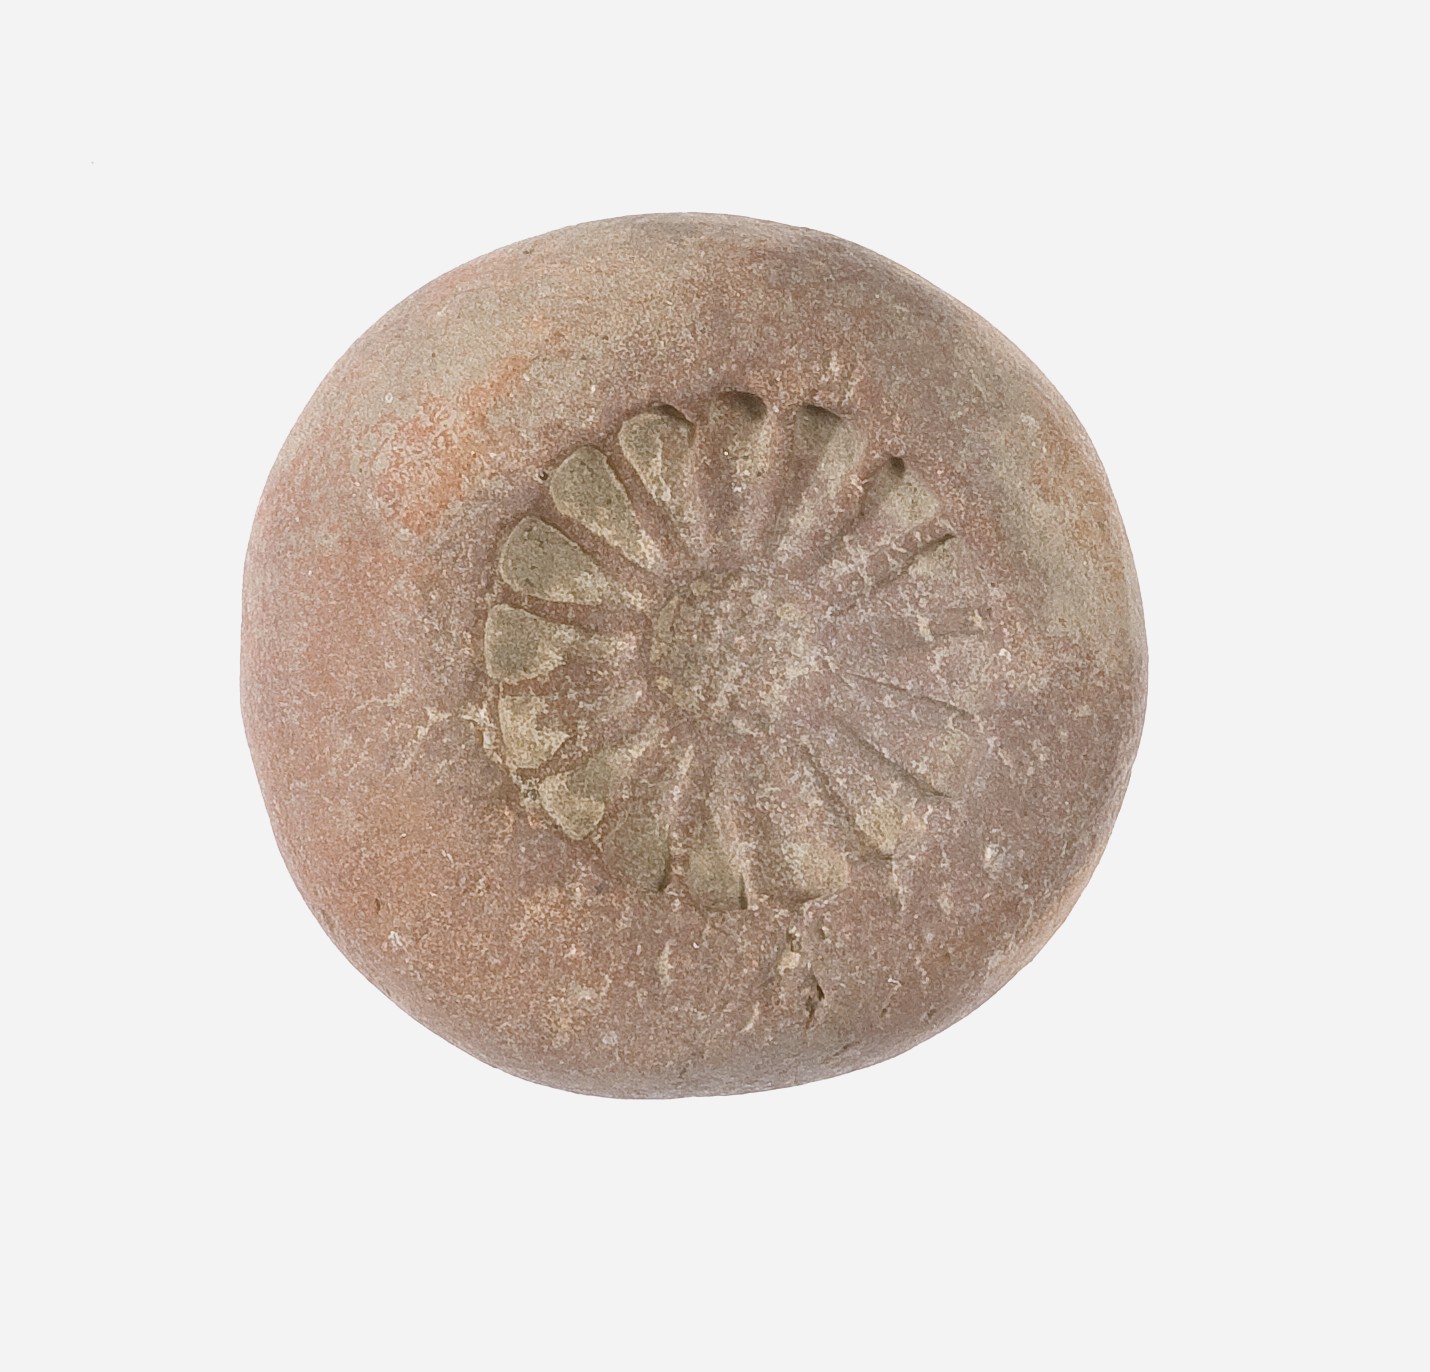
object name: mold, daisy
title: Small Daisy Mold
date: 1390-1352 BCE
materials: pottery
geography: egypt